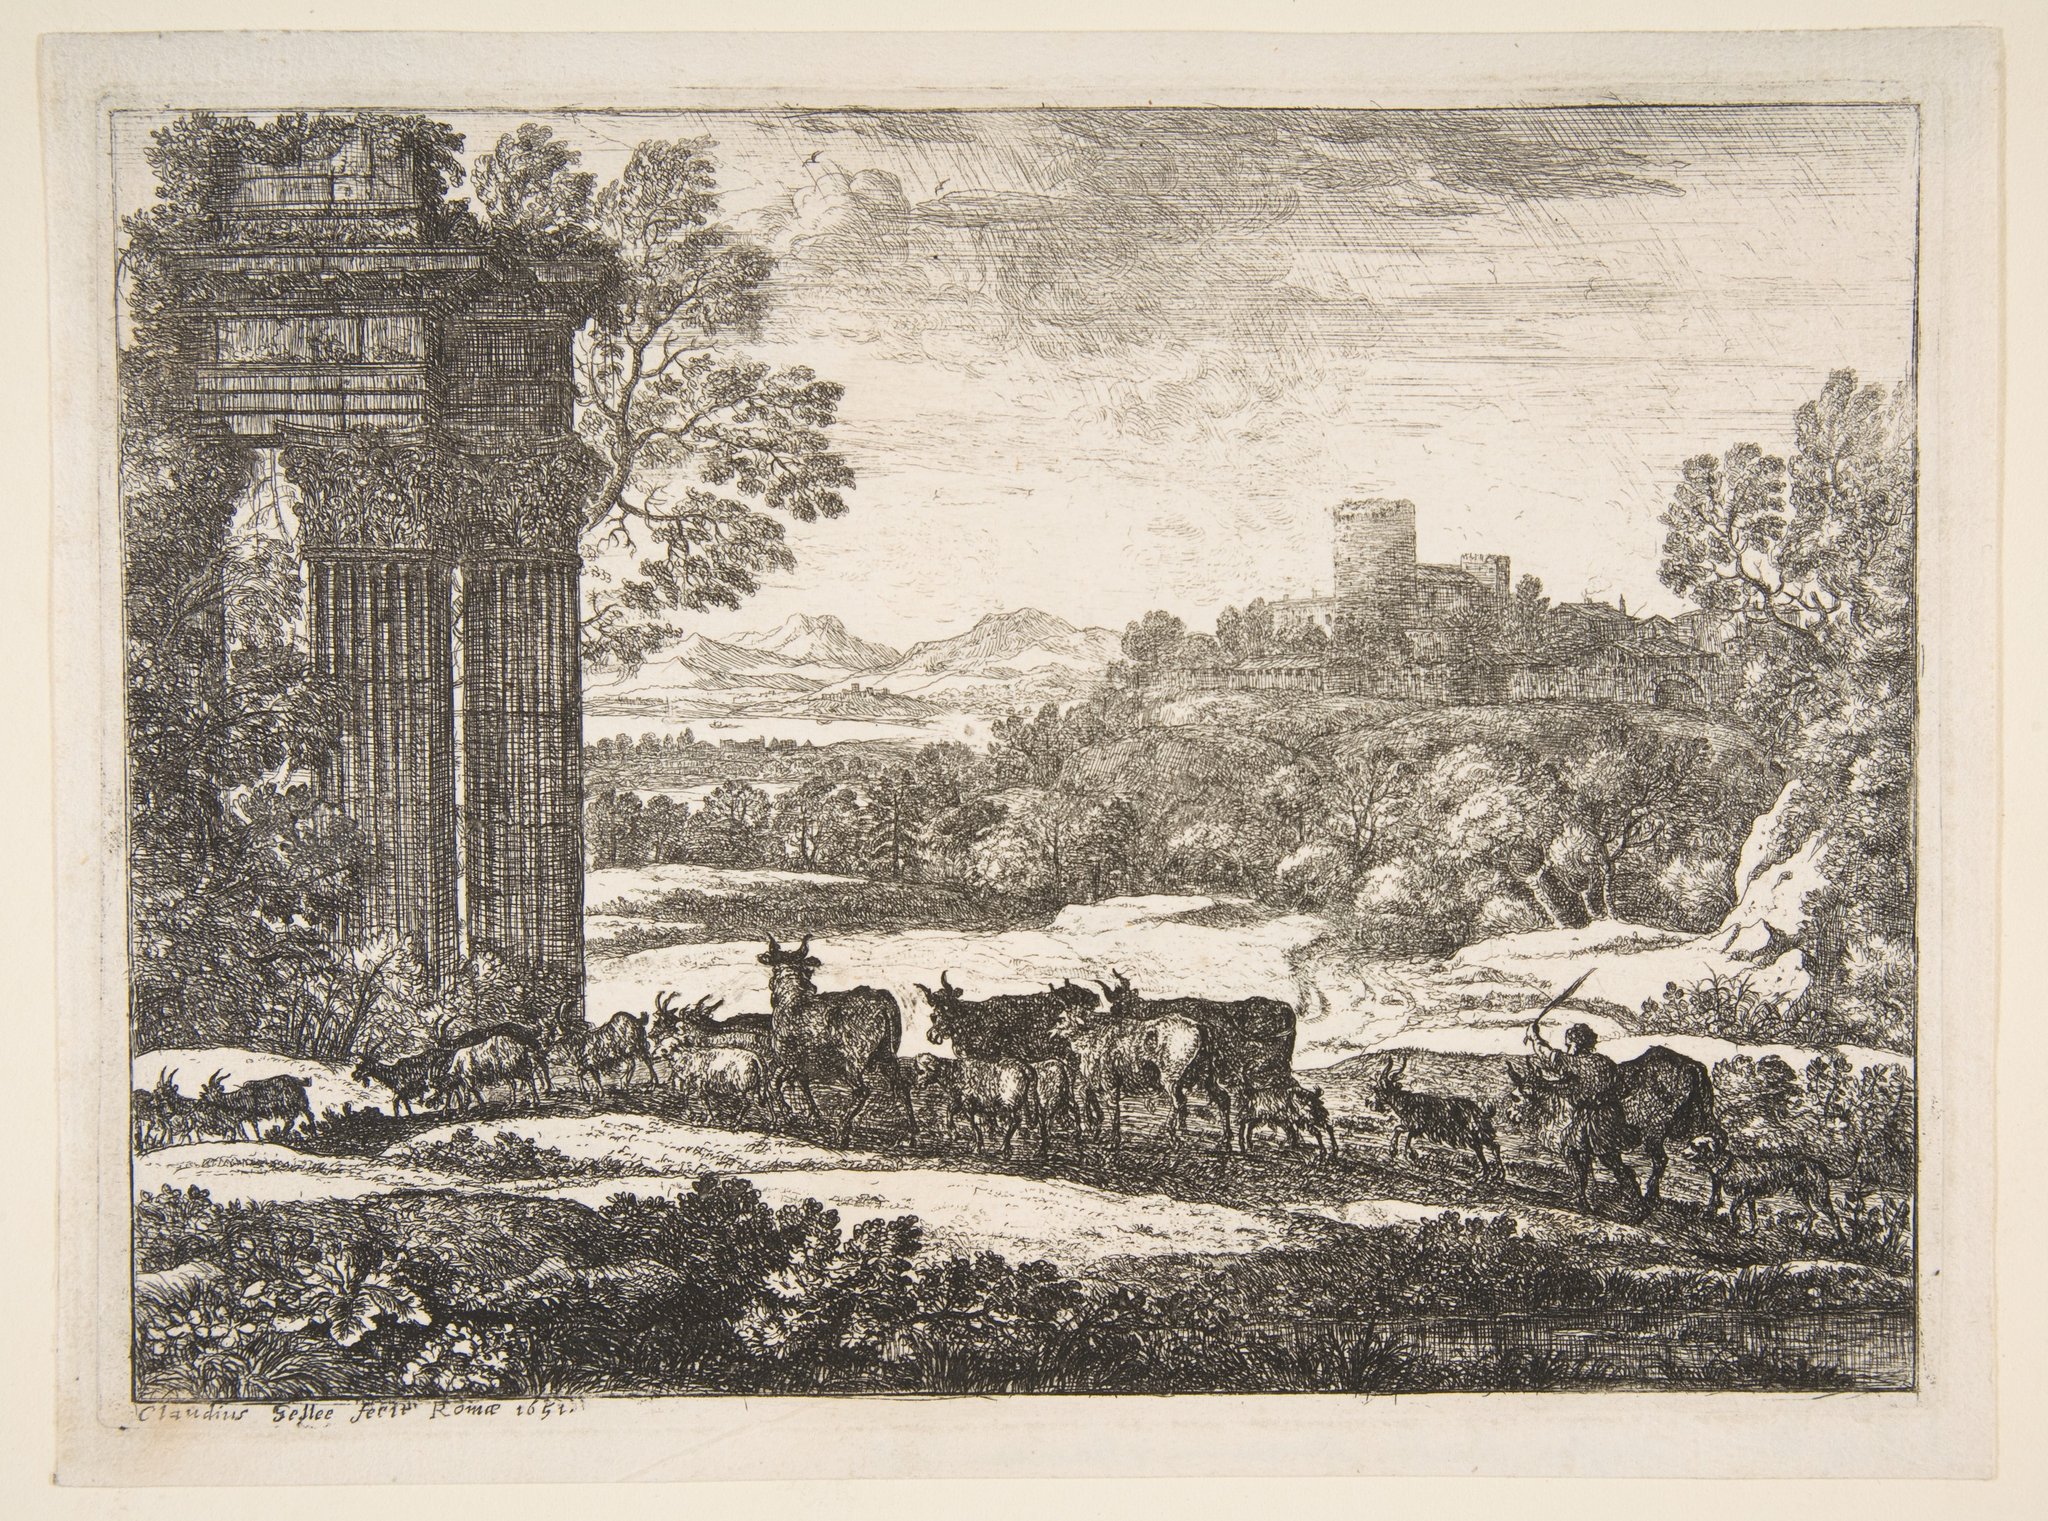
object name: print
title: The Herd Returning in Stormy Weather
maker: claude lorrain (claude gellée)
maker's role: artist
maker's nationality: french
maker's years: 1604-1682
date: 1651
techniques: etching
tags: animals,ruins,men,trees,storms